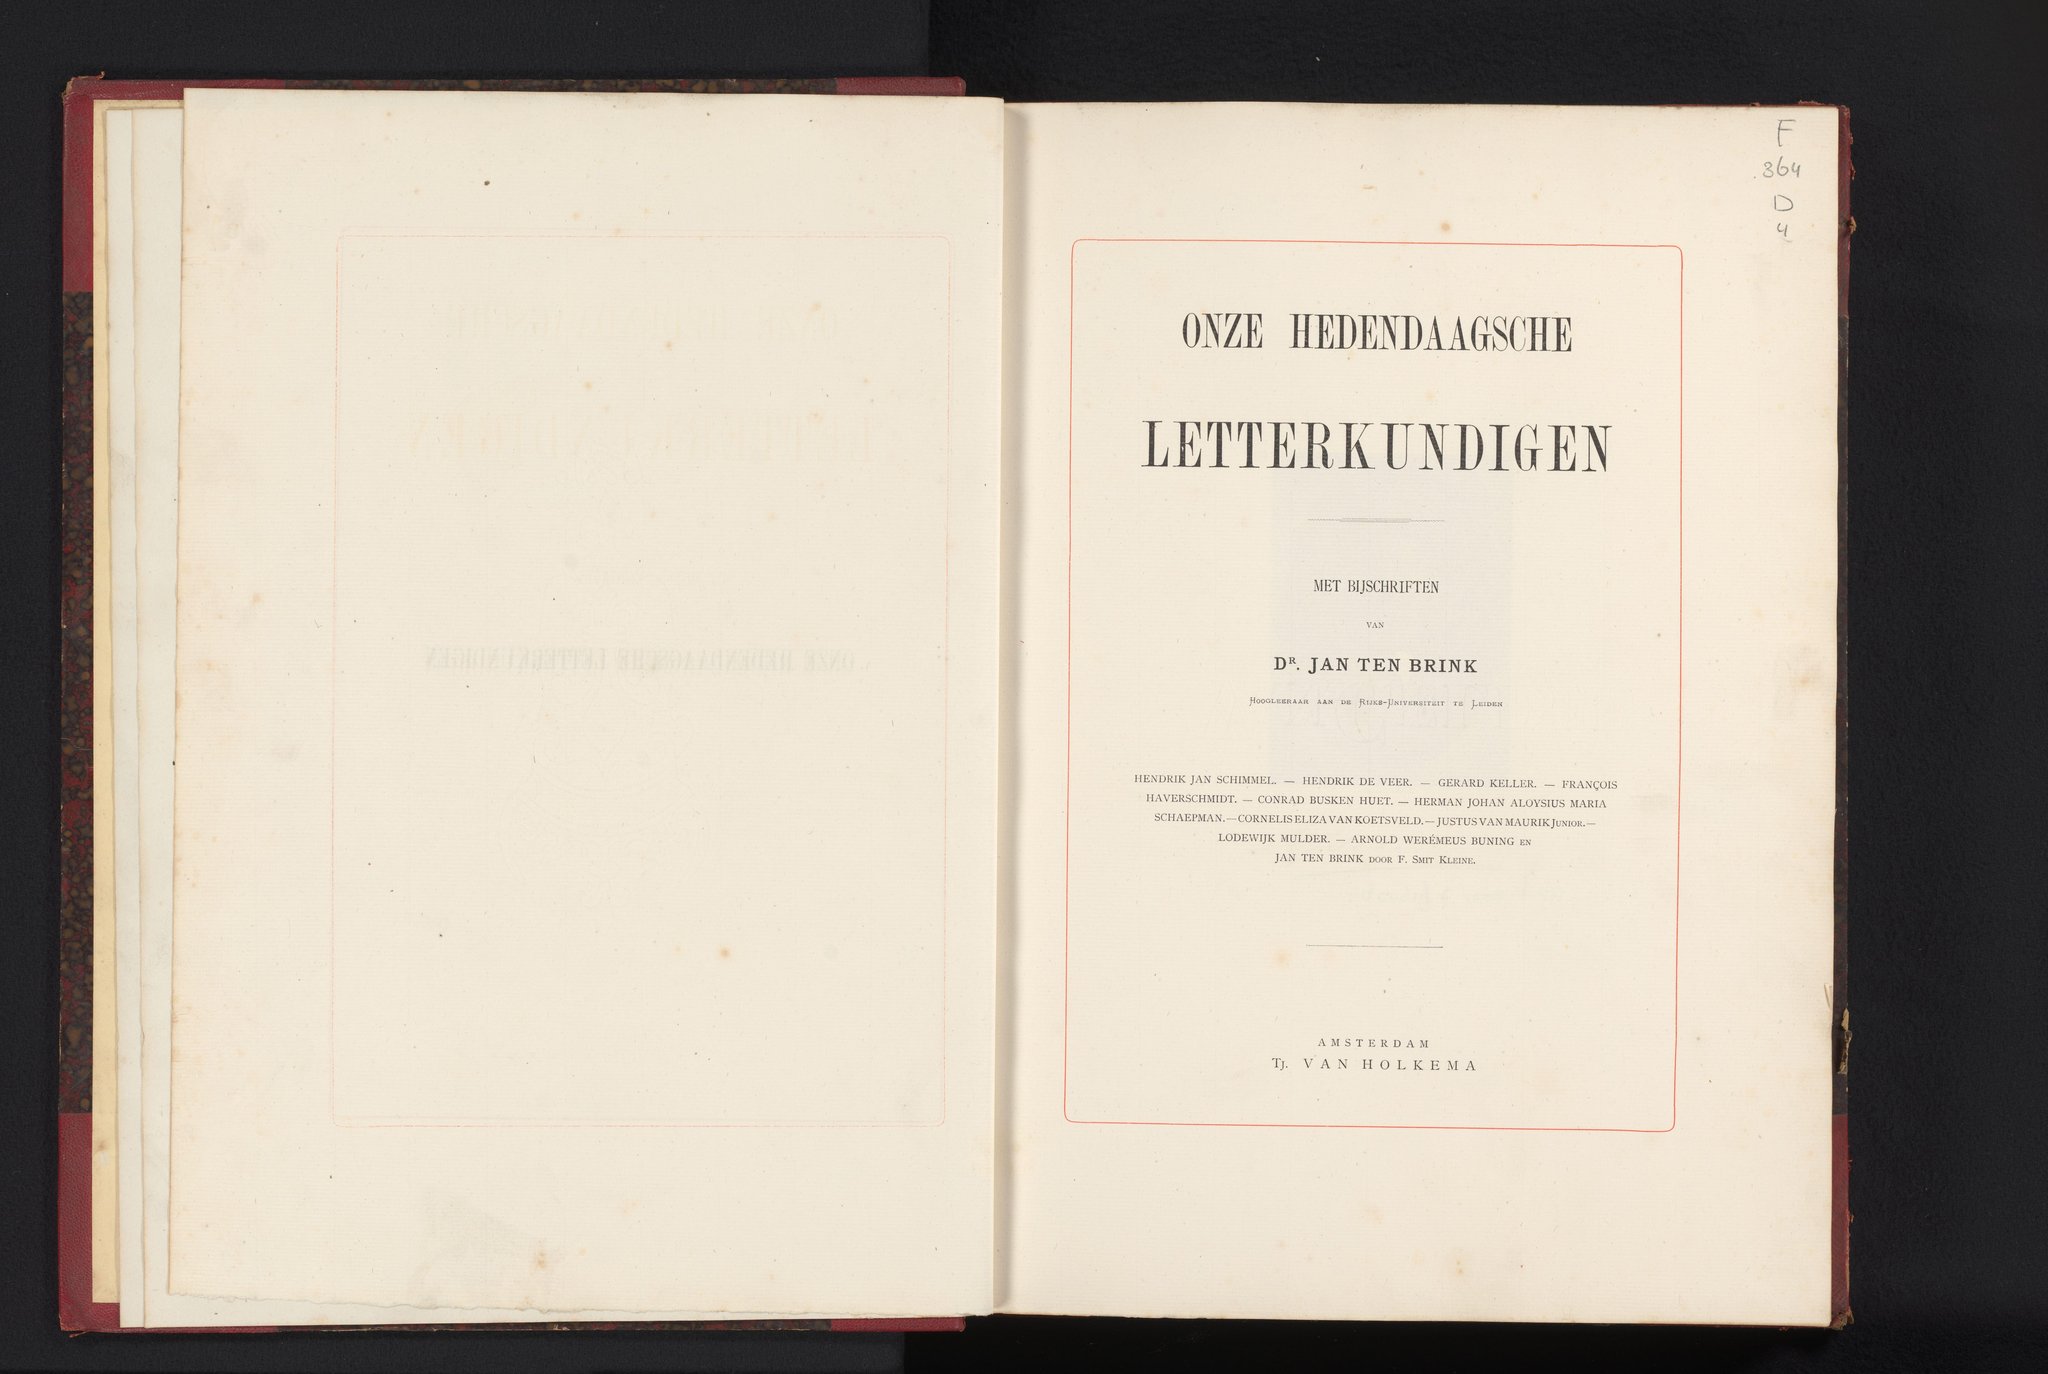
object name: book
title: Onze hedendaagsche letterkundigen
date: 1883-1887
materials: cardboard, leather, linen, paper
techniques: printing, woodburytype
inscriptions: bookplate: ‘Barend van den Kieboom zijn boek’, date: ‘NOV 1994’, annotation: ‘2 dln’